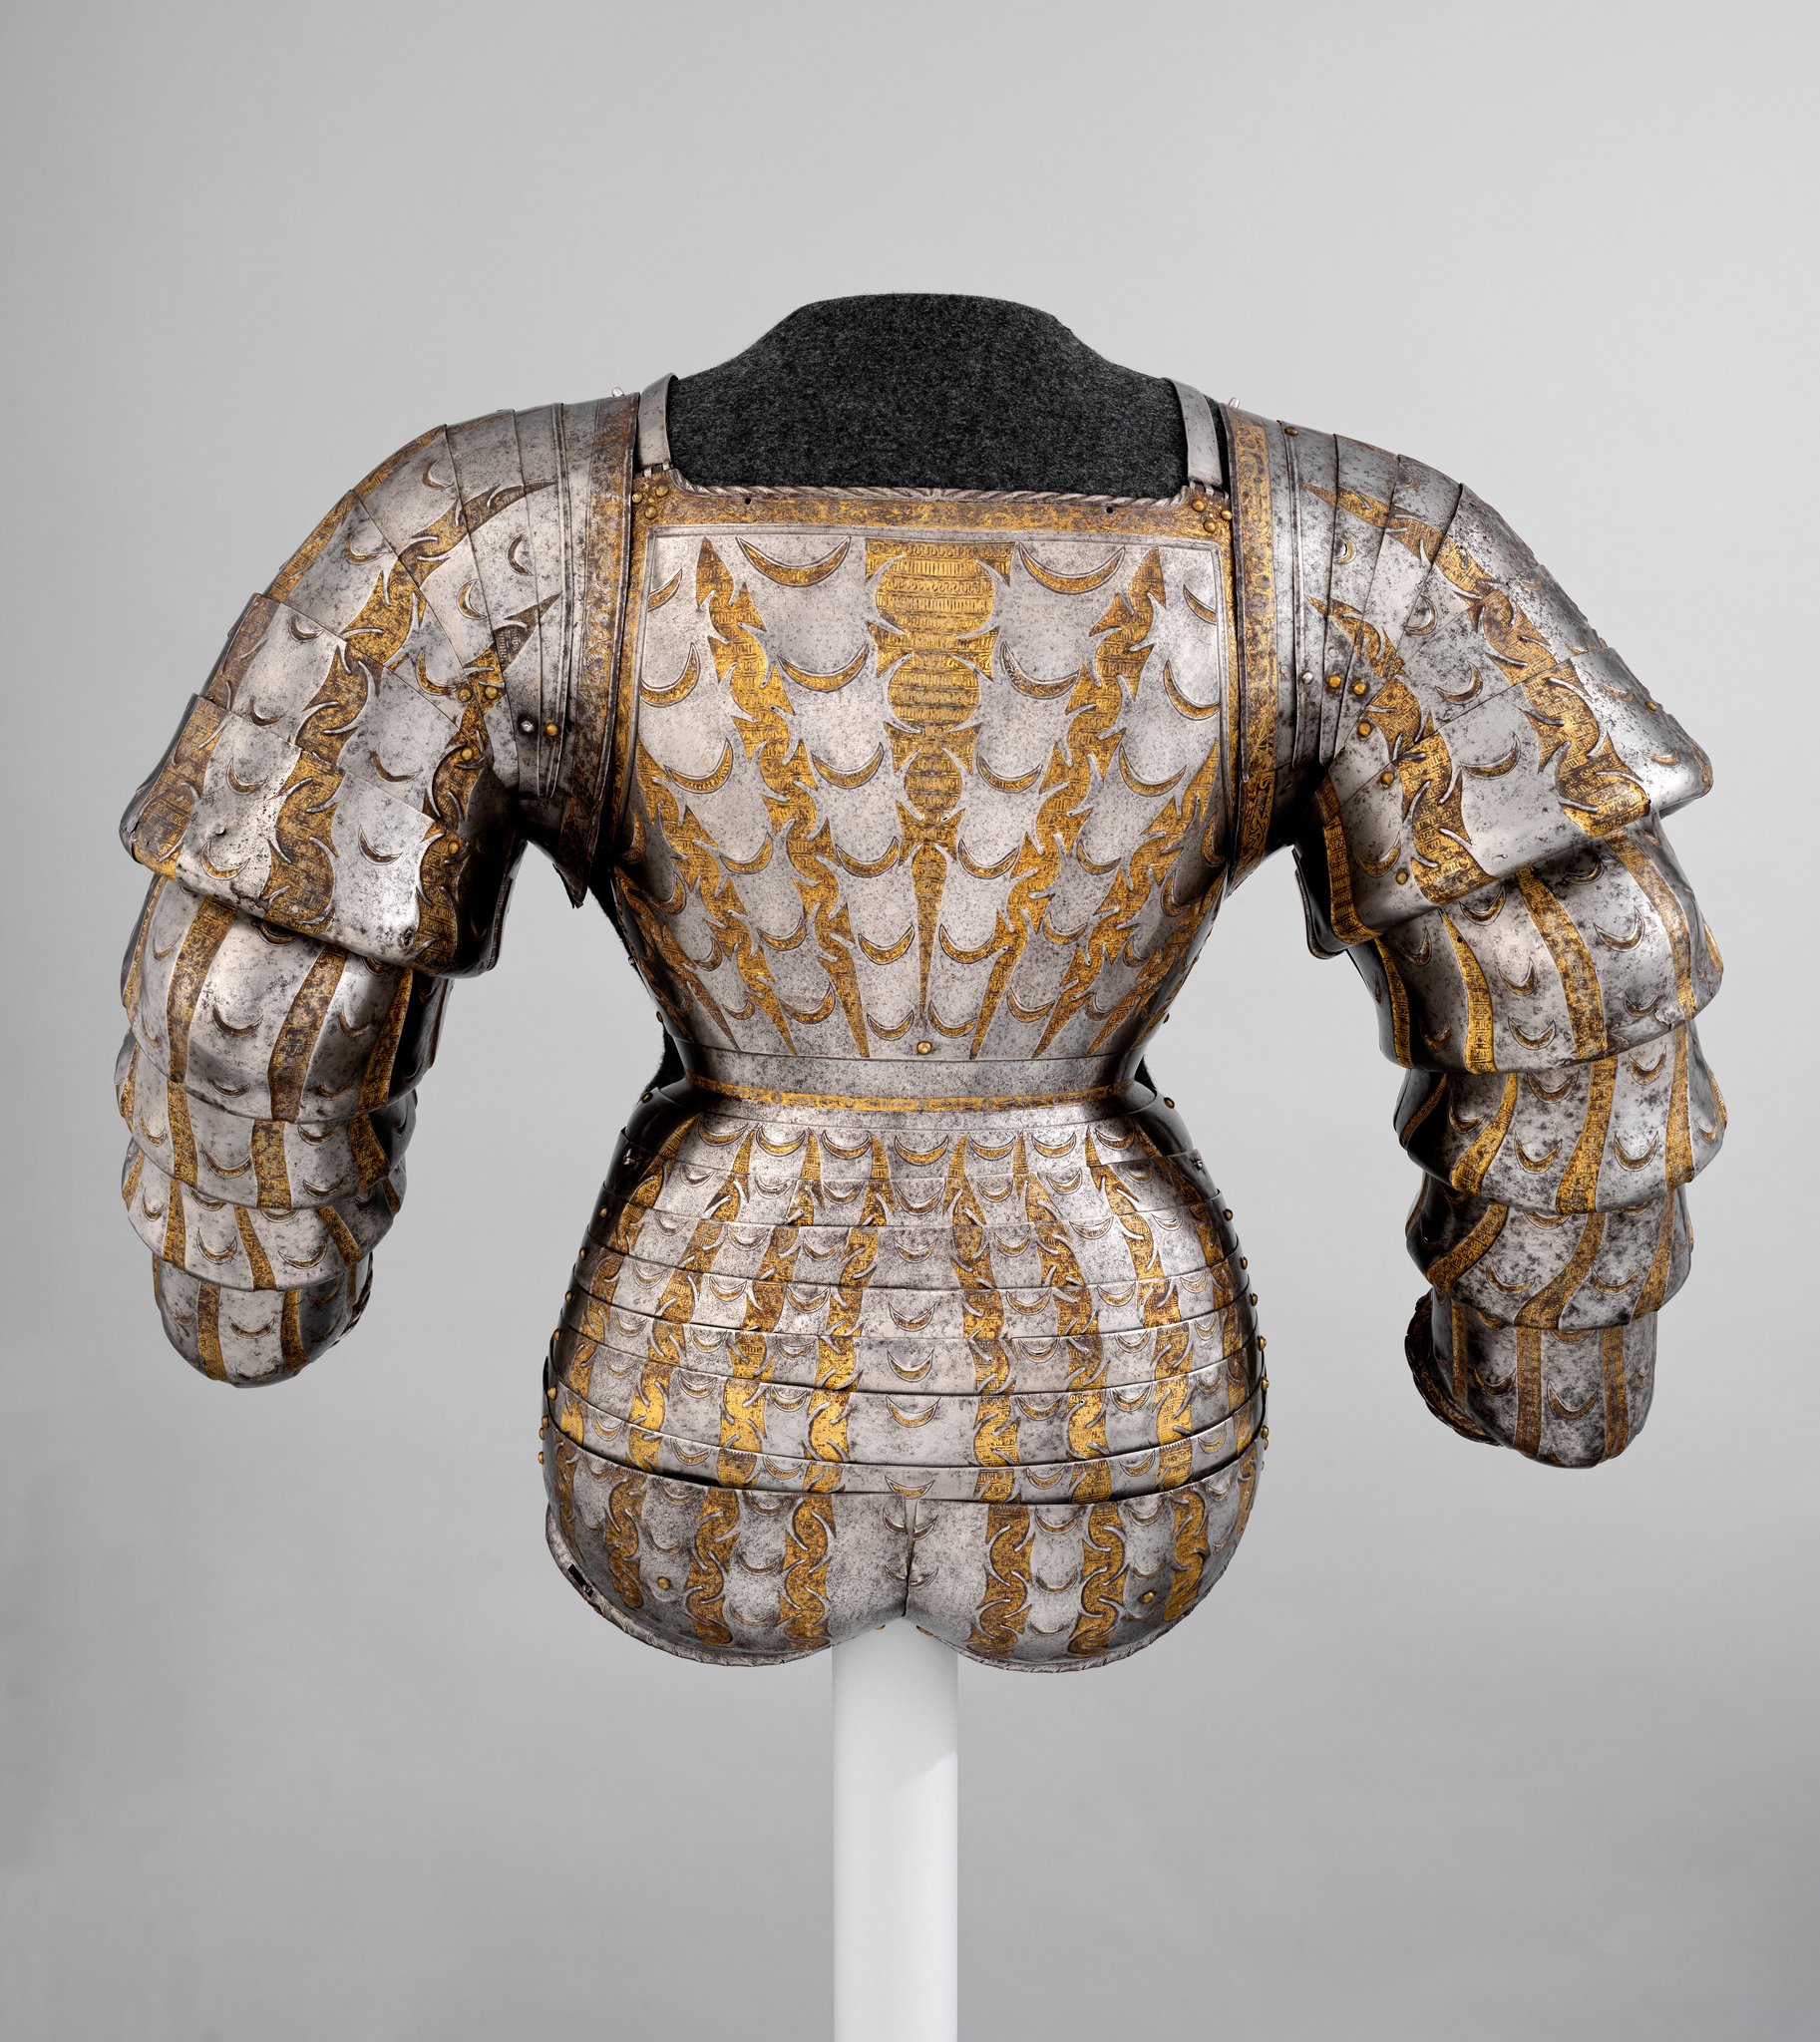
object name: portion of a costume armor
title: Portions of a Costume Armor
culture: german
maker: kolman helmschmid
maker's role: armorer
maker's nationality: german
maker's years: 1471-1532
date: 1525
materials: copper alloy, gold, steel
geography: germany